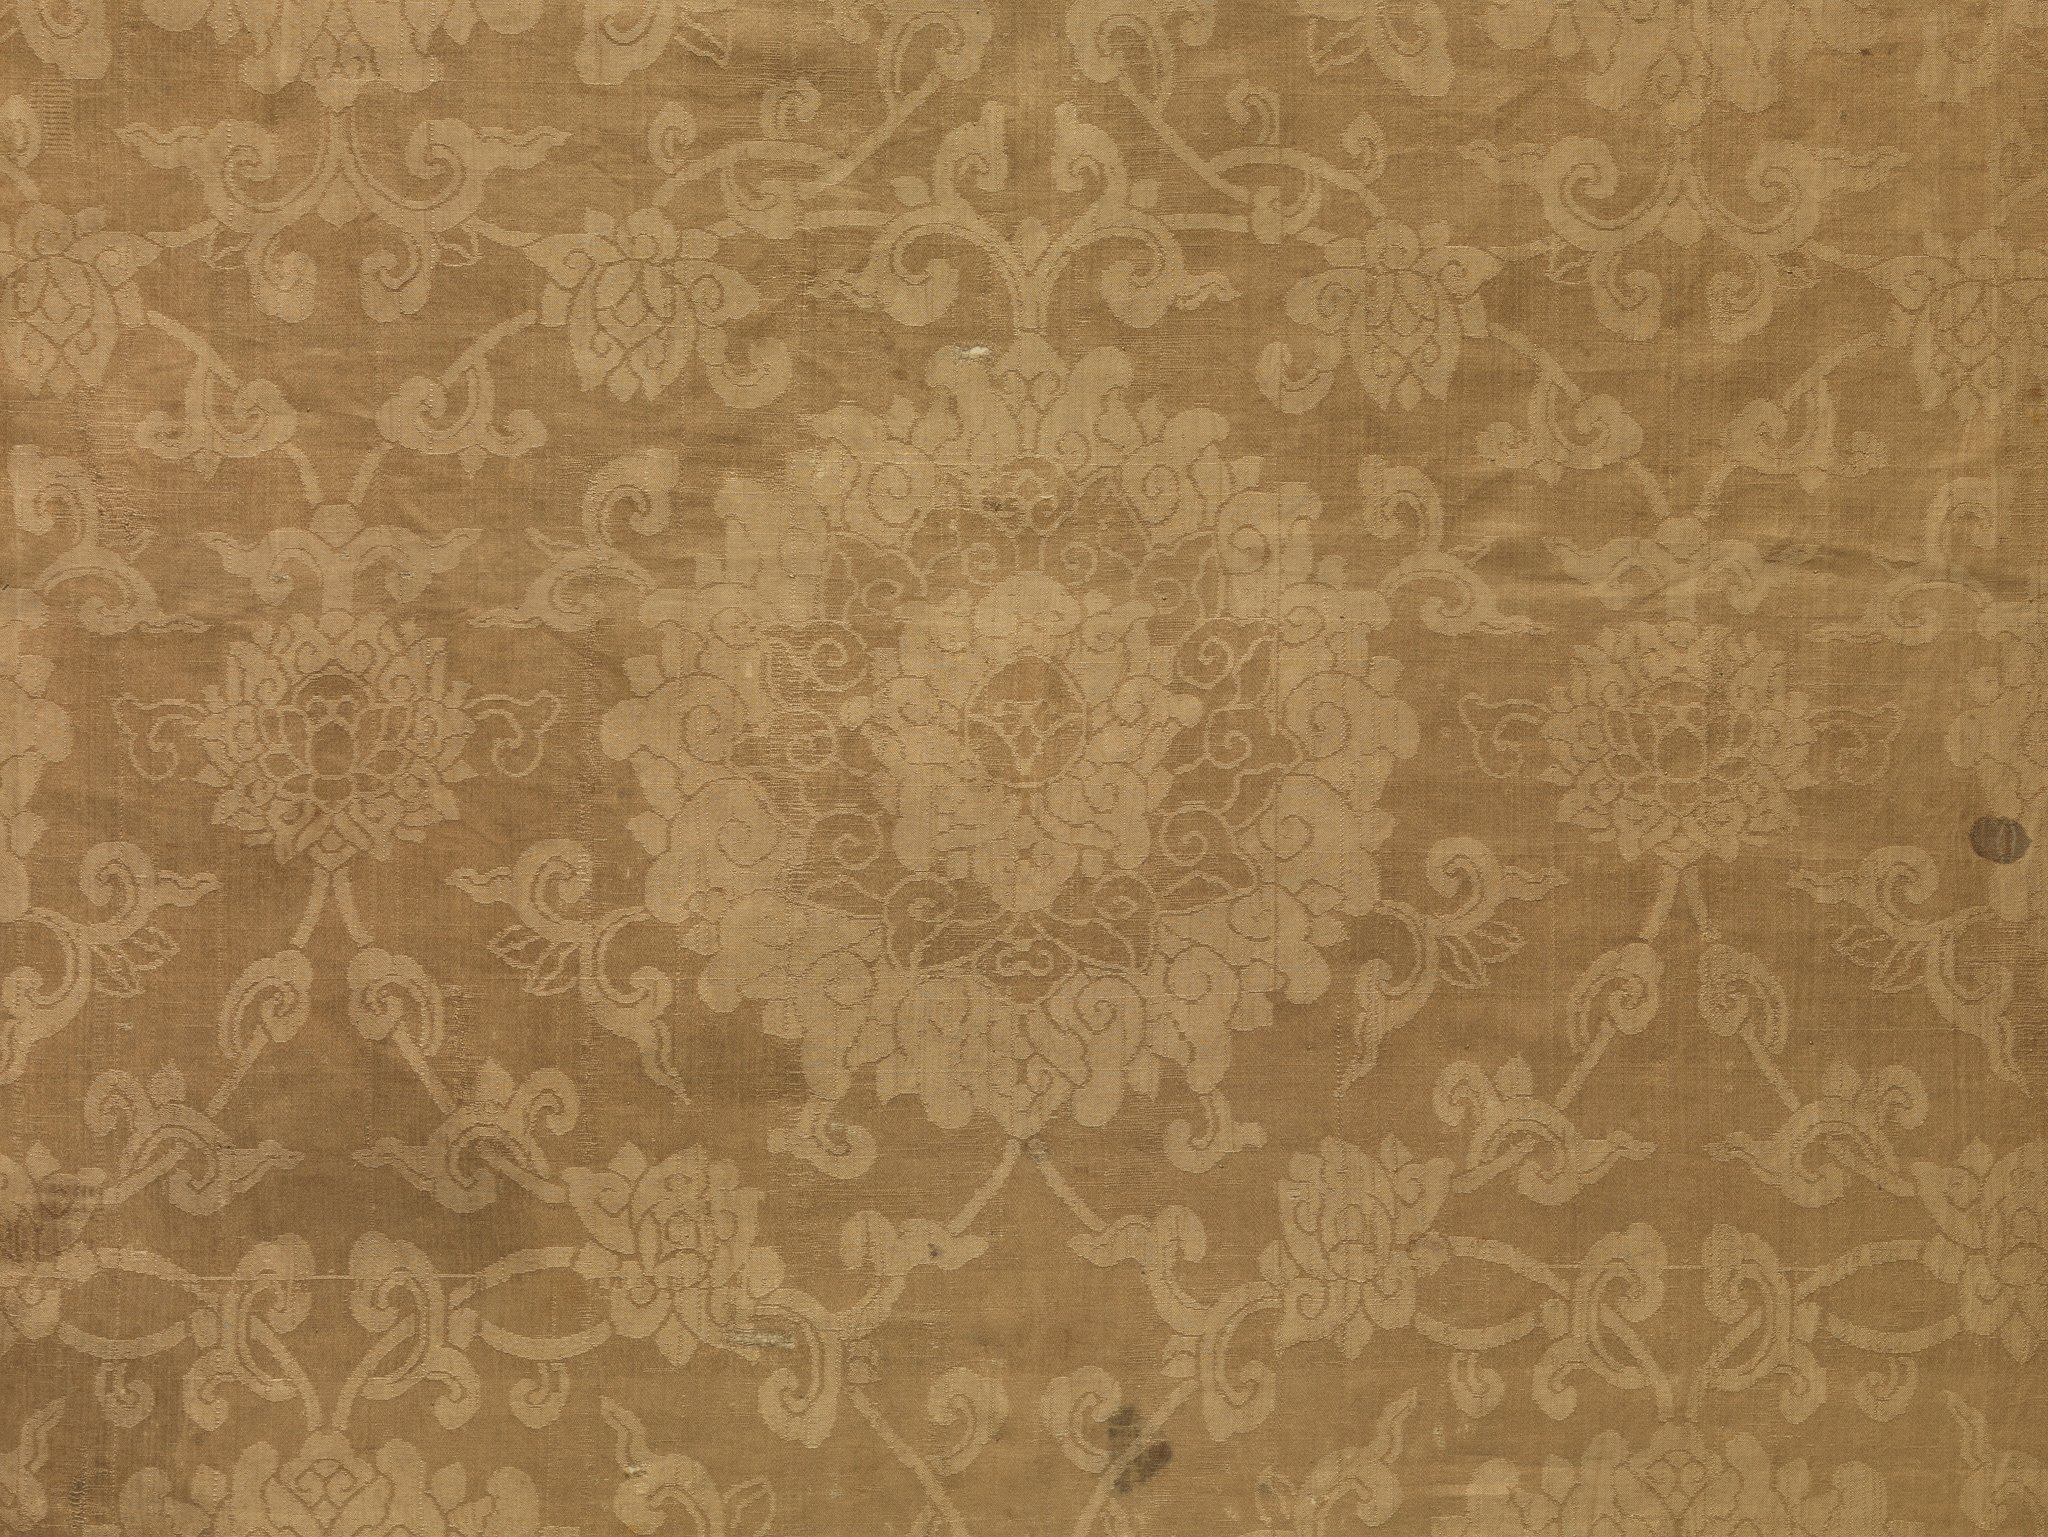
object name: panel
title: Panel with Medallion of Longevity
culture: chinese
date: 1501-1633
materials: silk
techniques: damask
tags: flowers